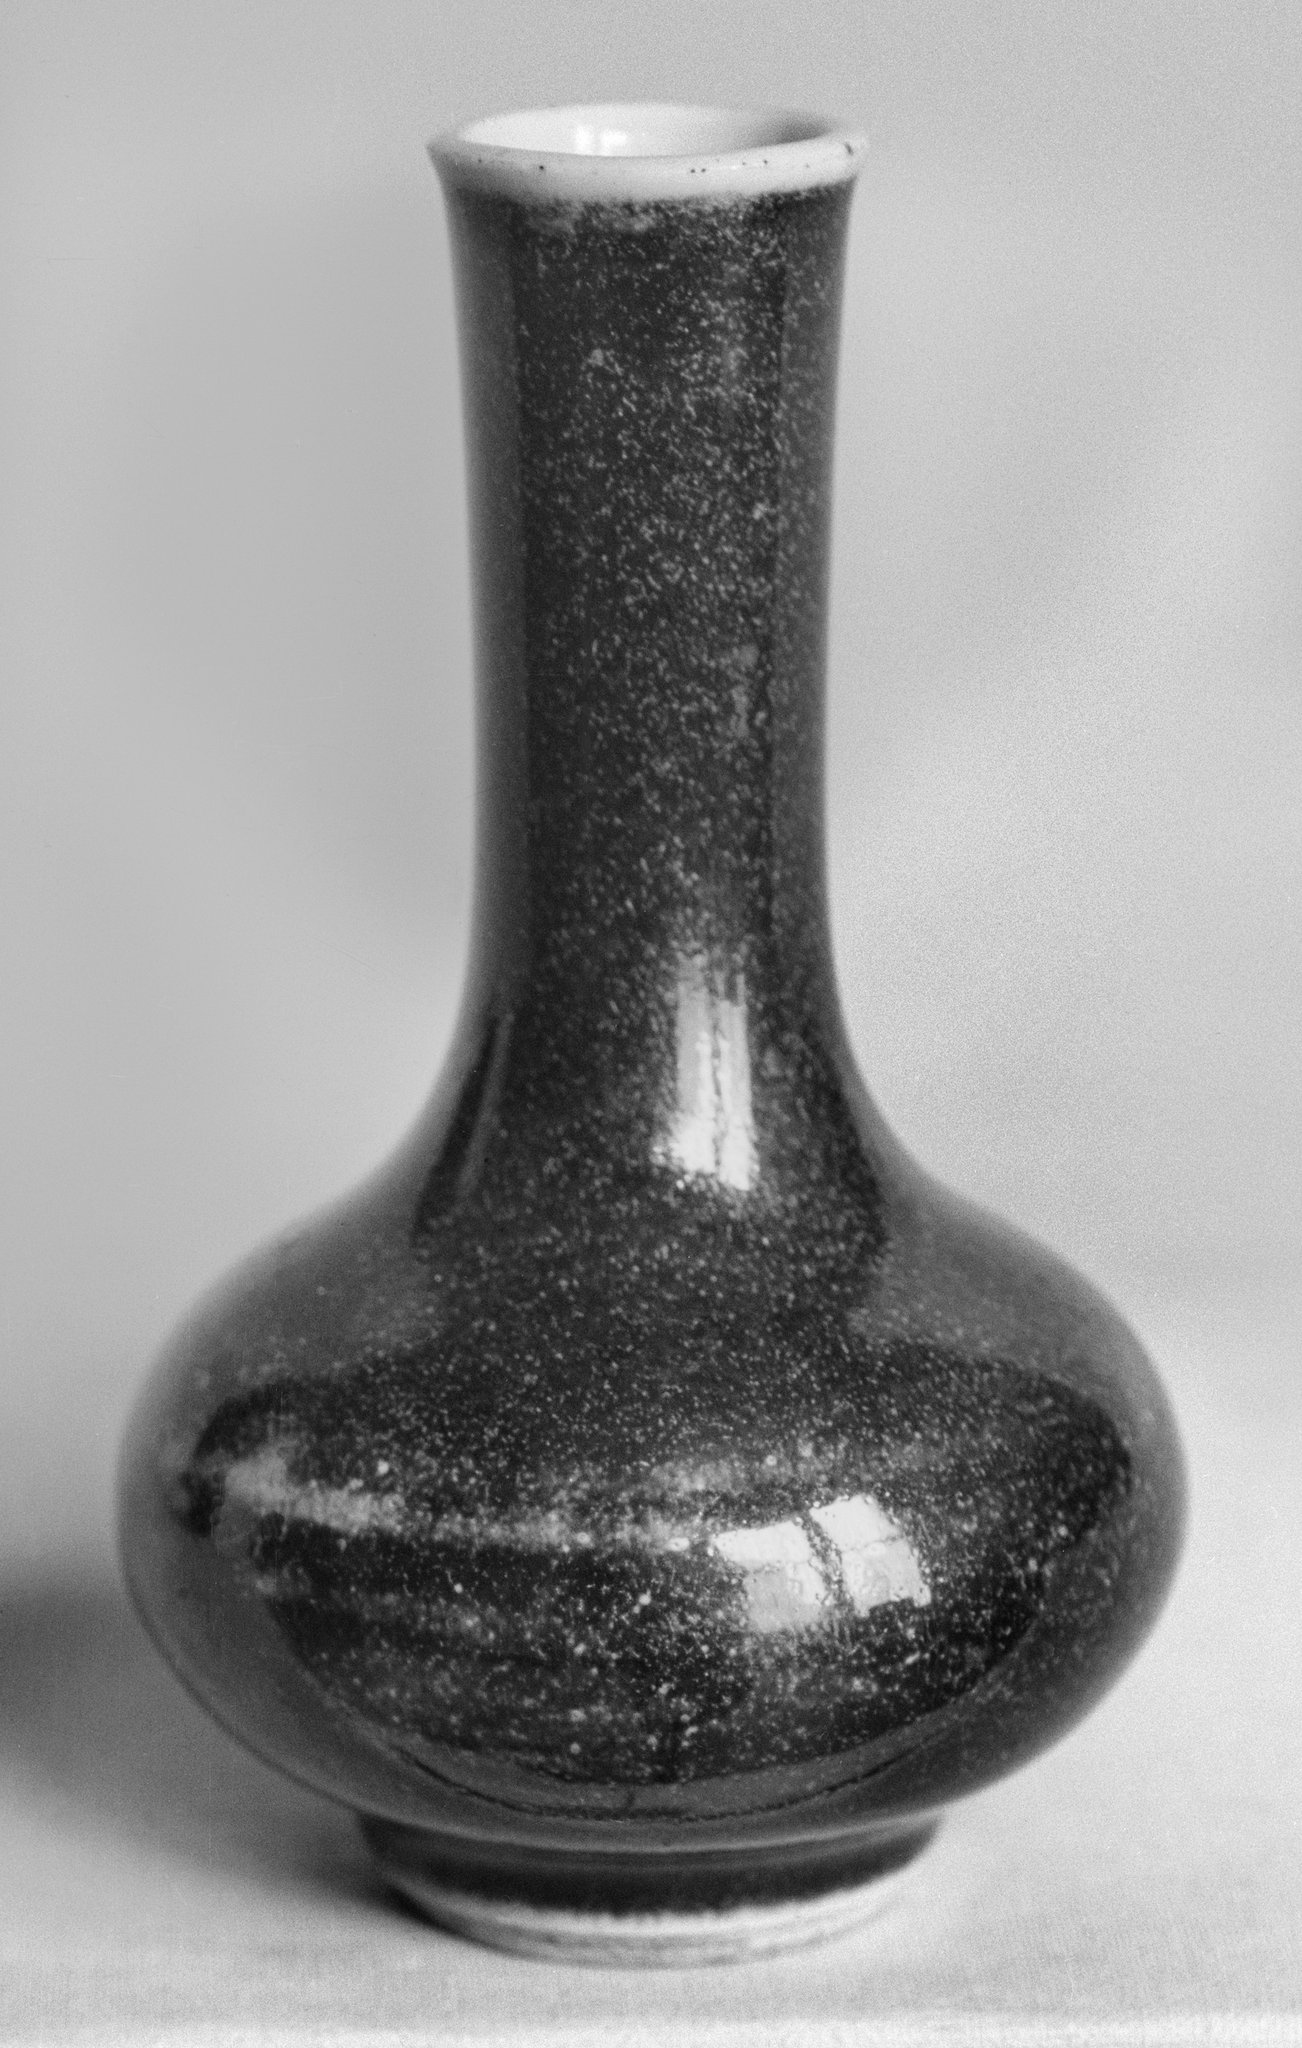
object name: bottle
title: Miniature Bottle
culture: chinese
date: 1662-1722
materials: porcelain